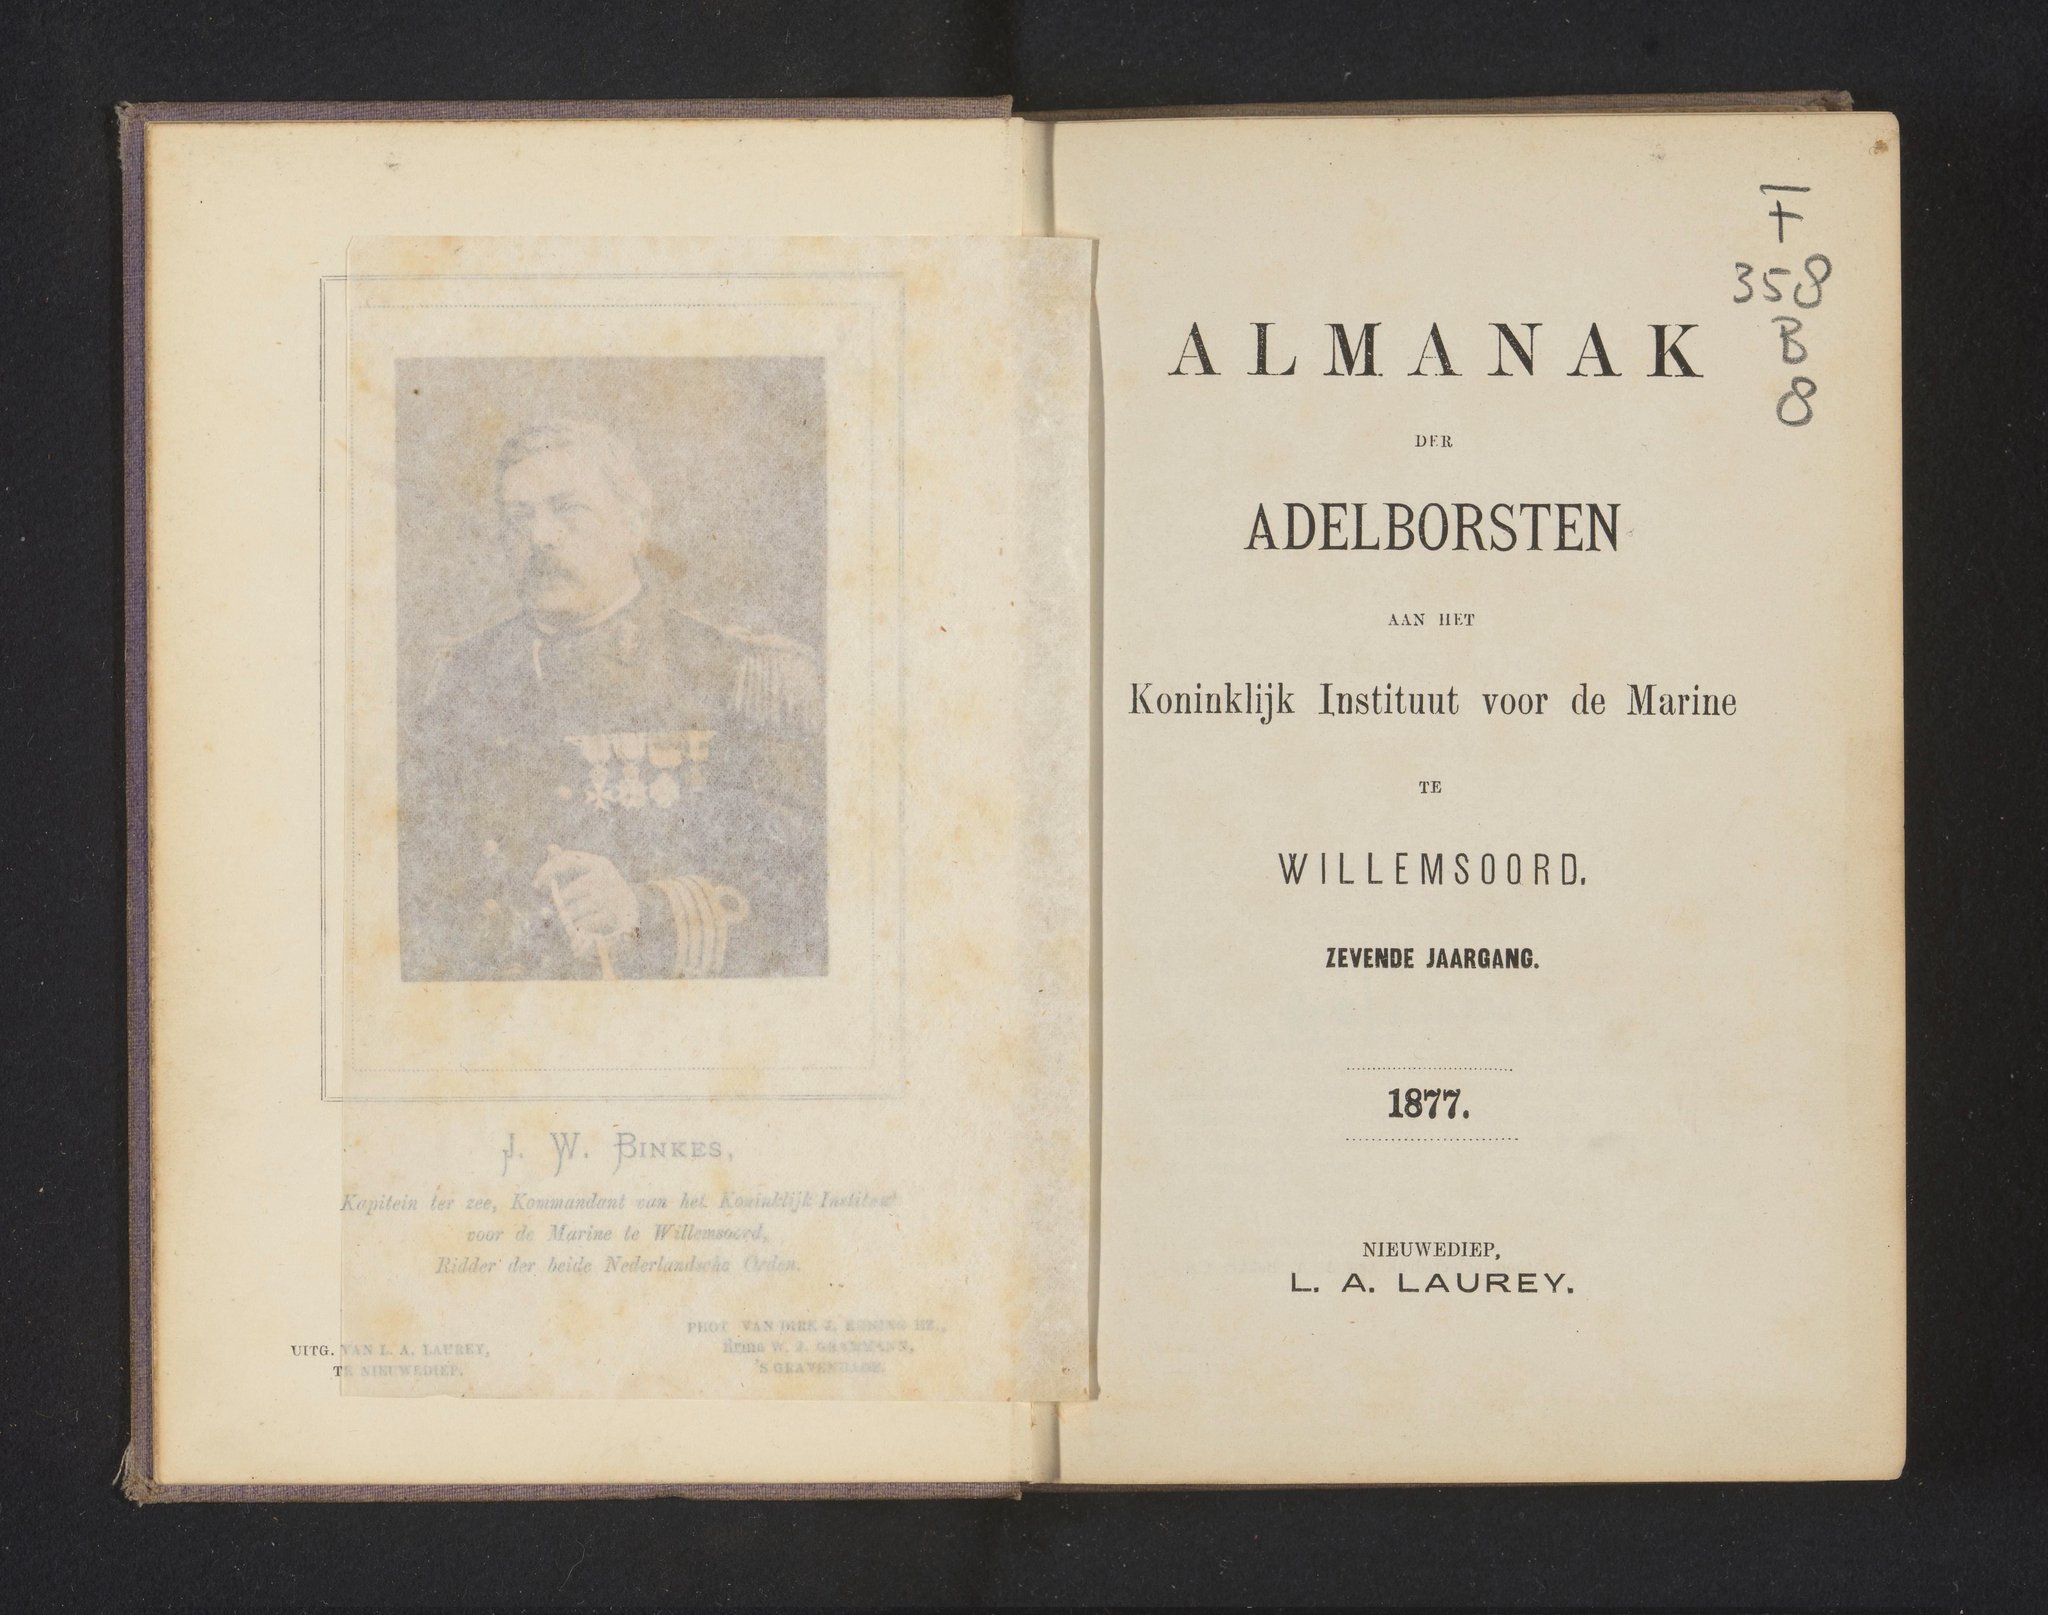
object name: book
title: Almanak der adelborsten aan het Koninklijk Instituut voor de Marine te Willemsoord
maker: laurey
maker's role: publisher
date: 1877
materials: cardboard, linen, paper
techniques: albumen print, printing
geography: nieuwediep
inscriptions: annotation: ‘MAR/ 1993’, number: ‘37.50’